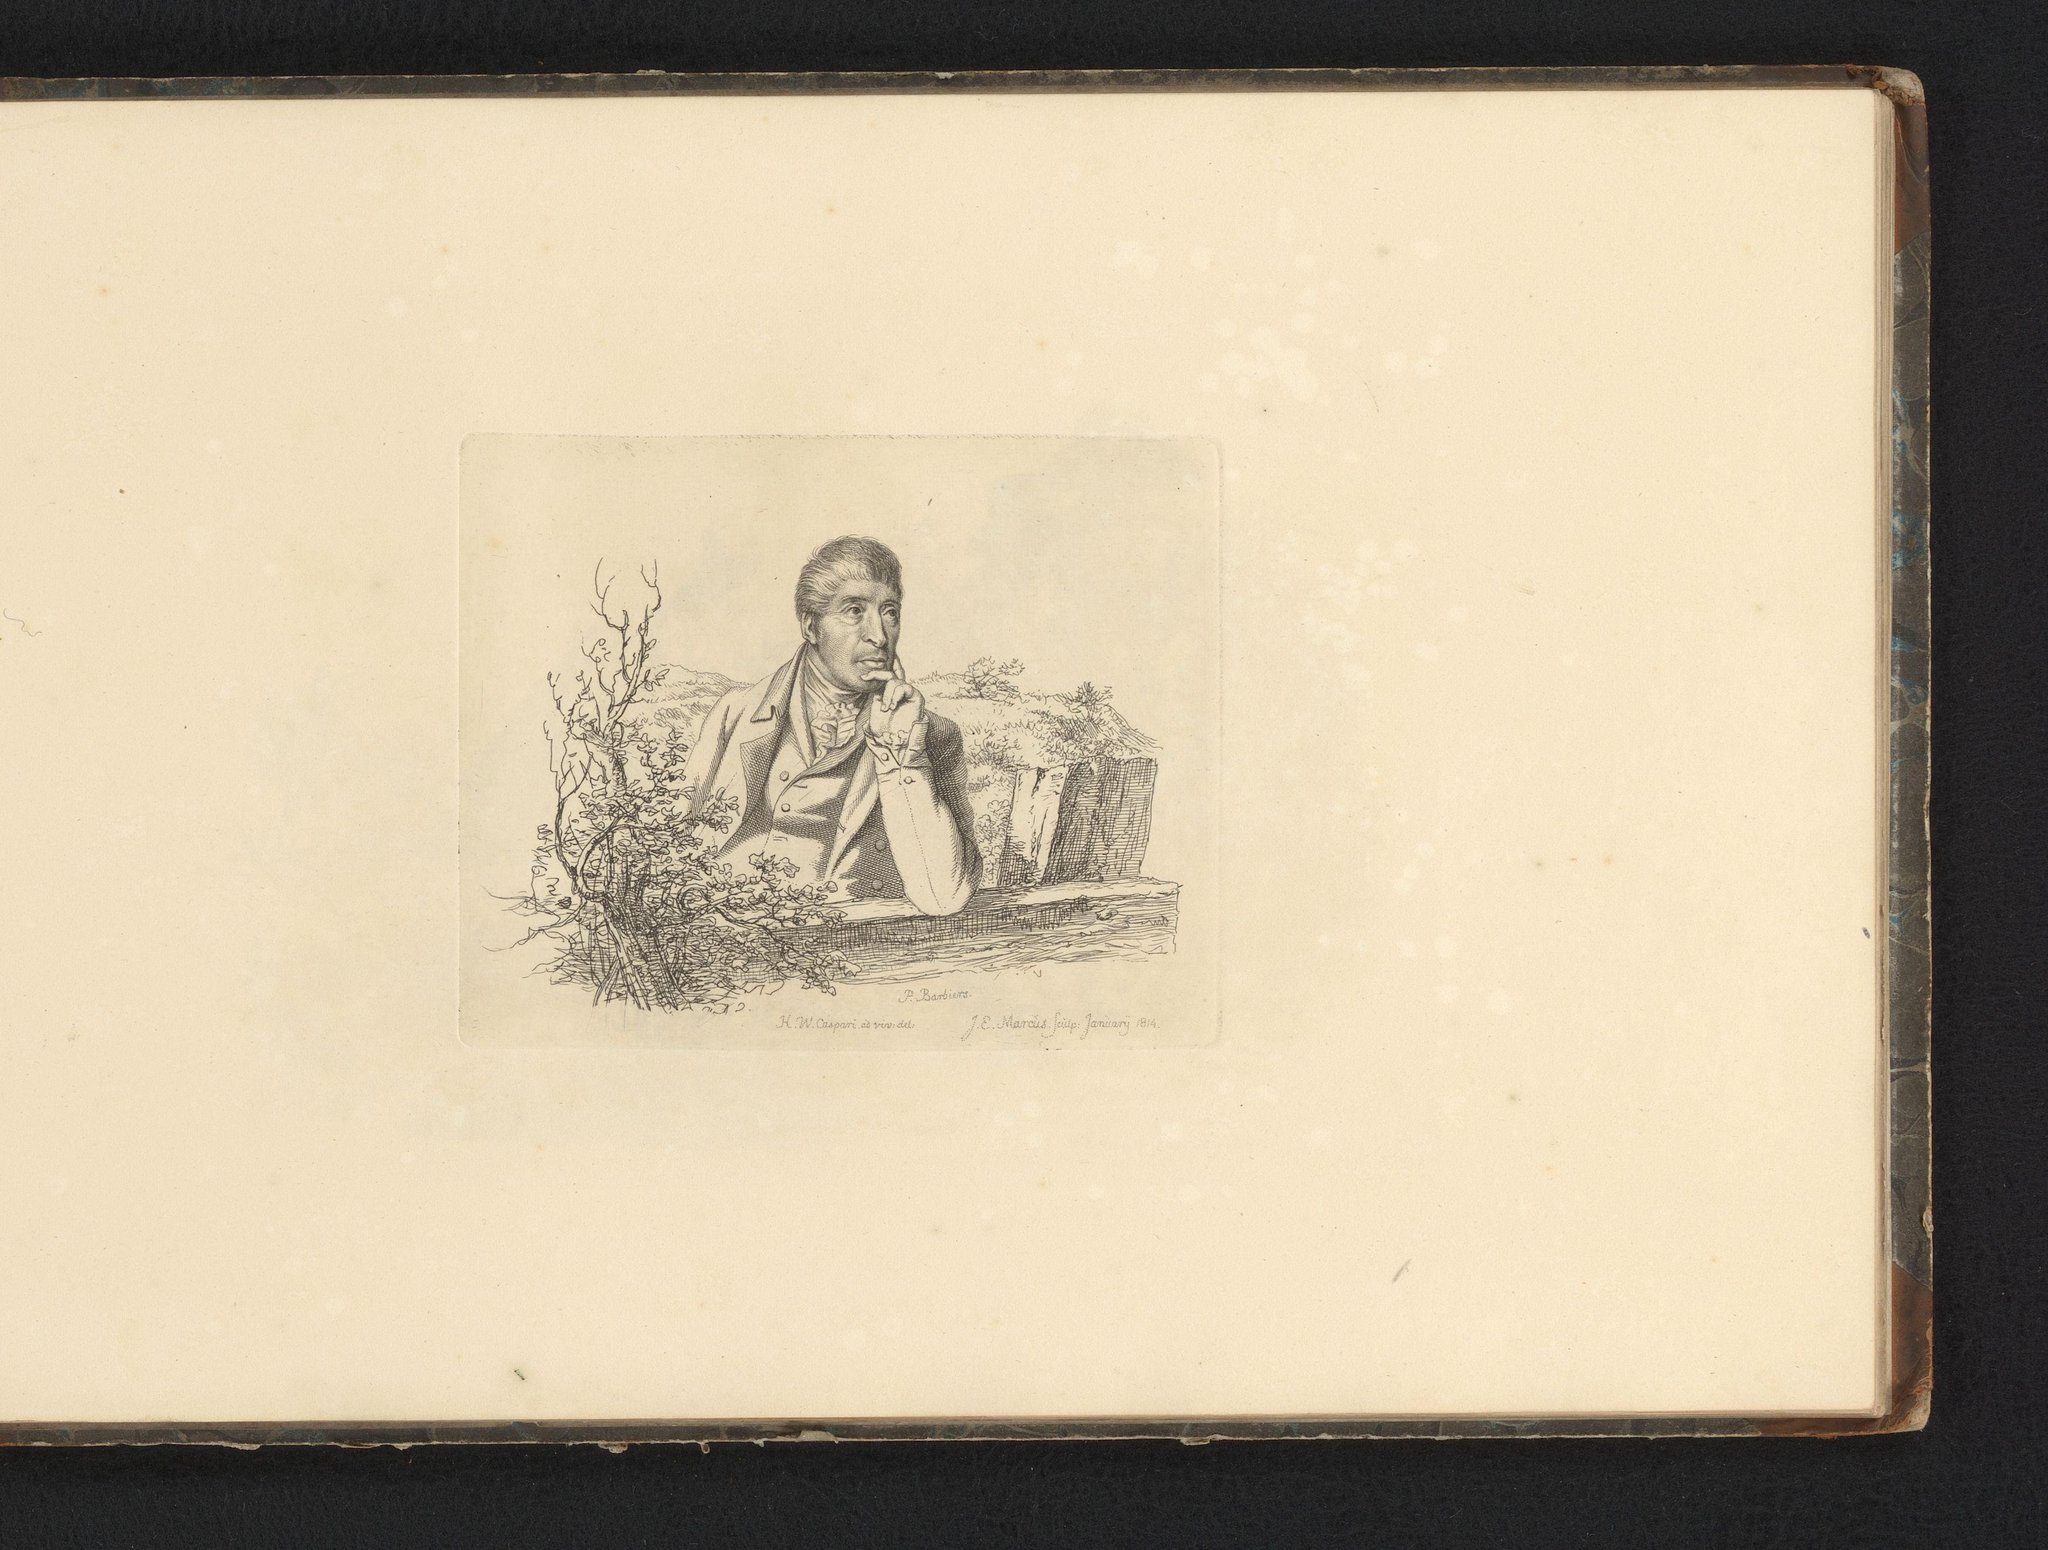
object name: print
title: Studiebeelden en fragmenten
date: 1801-1814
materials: paper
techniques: etching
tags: draughtsman, pieter pietersz. barbiers, portrait, self-portrait of artist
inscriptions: date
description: Deze prent maakt deel uit van een album.